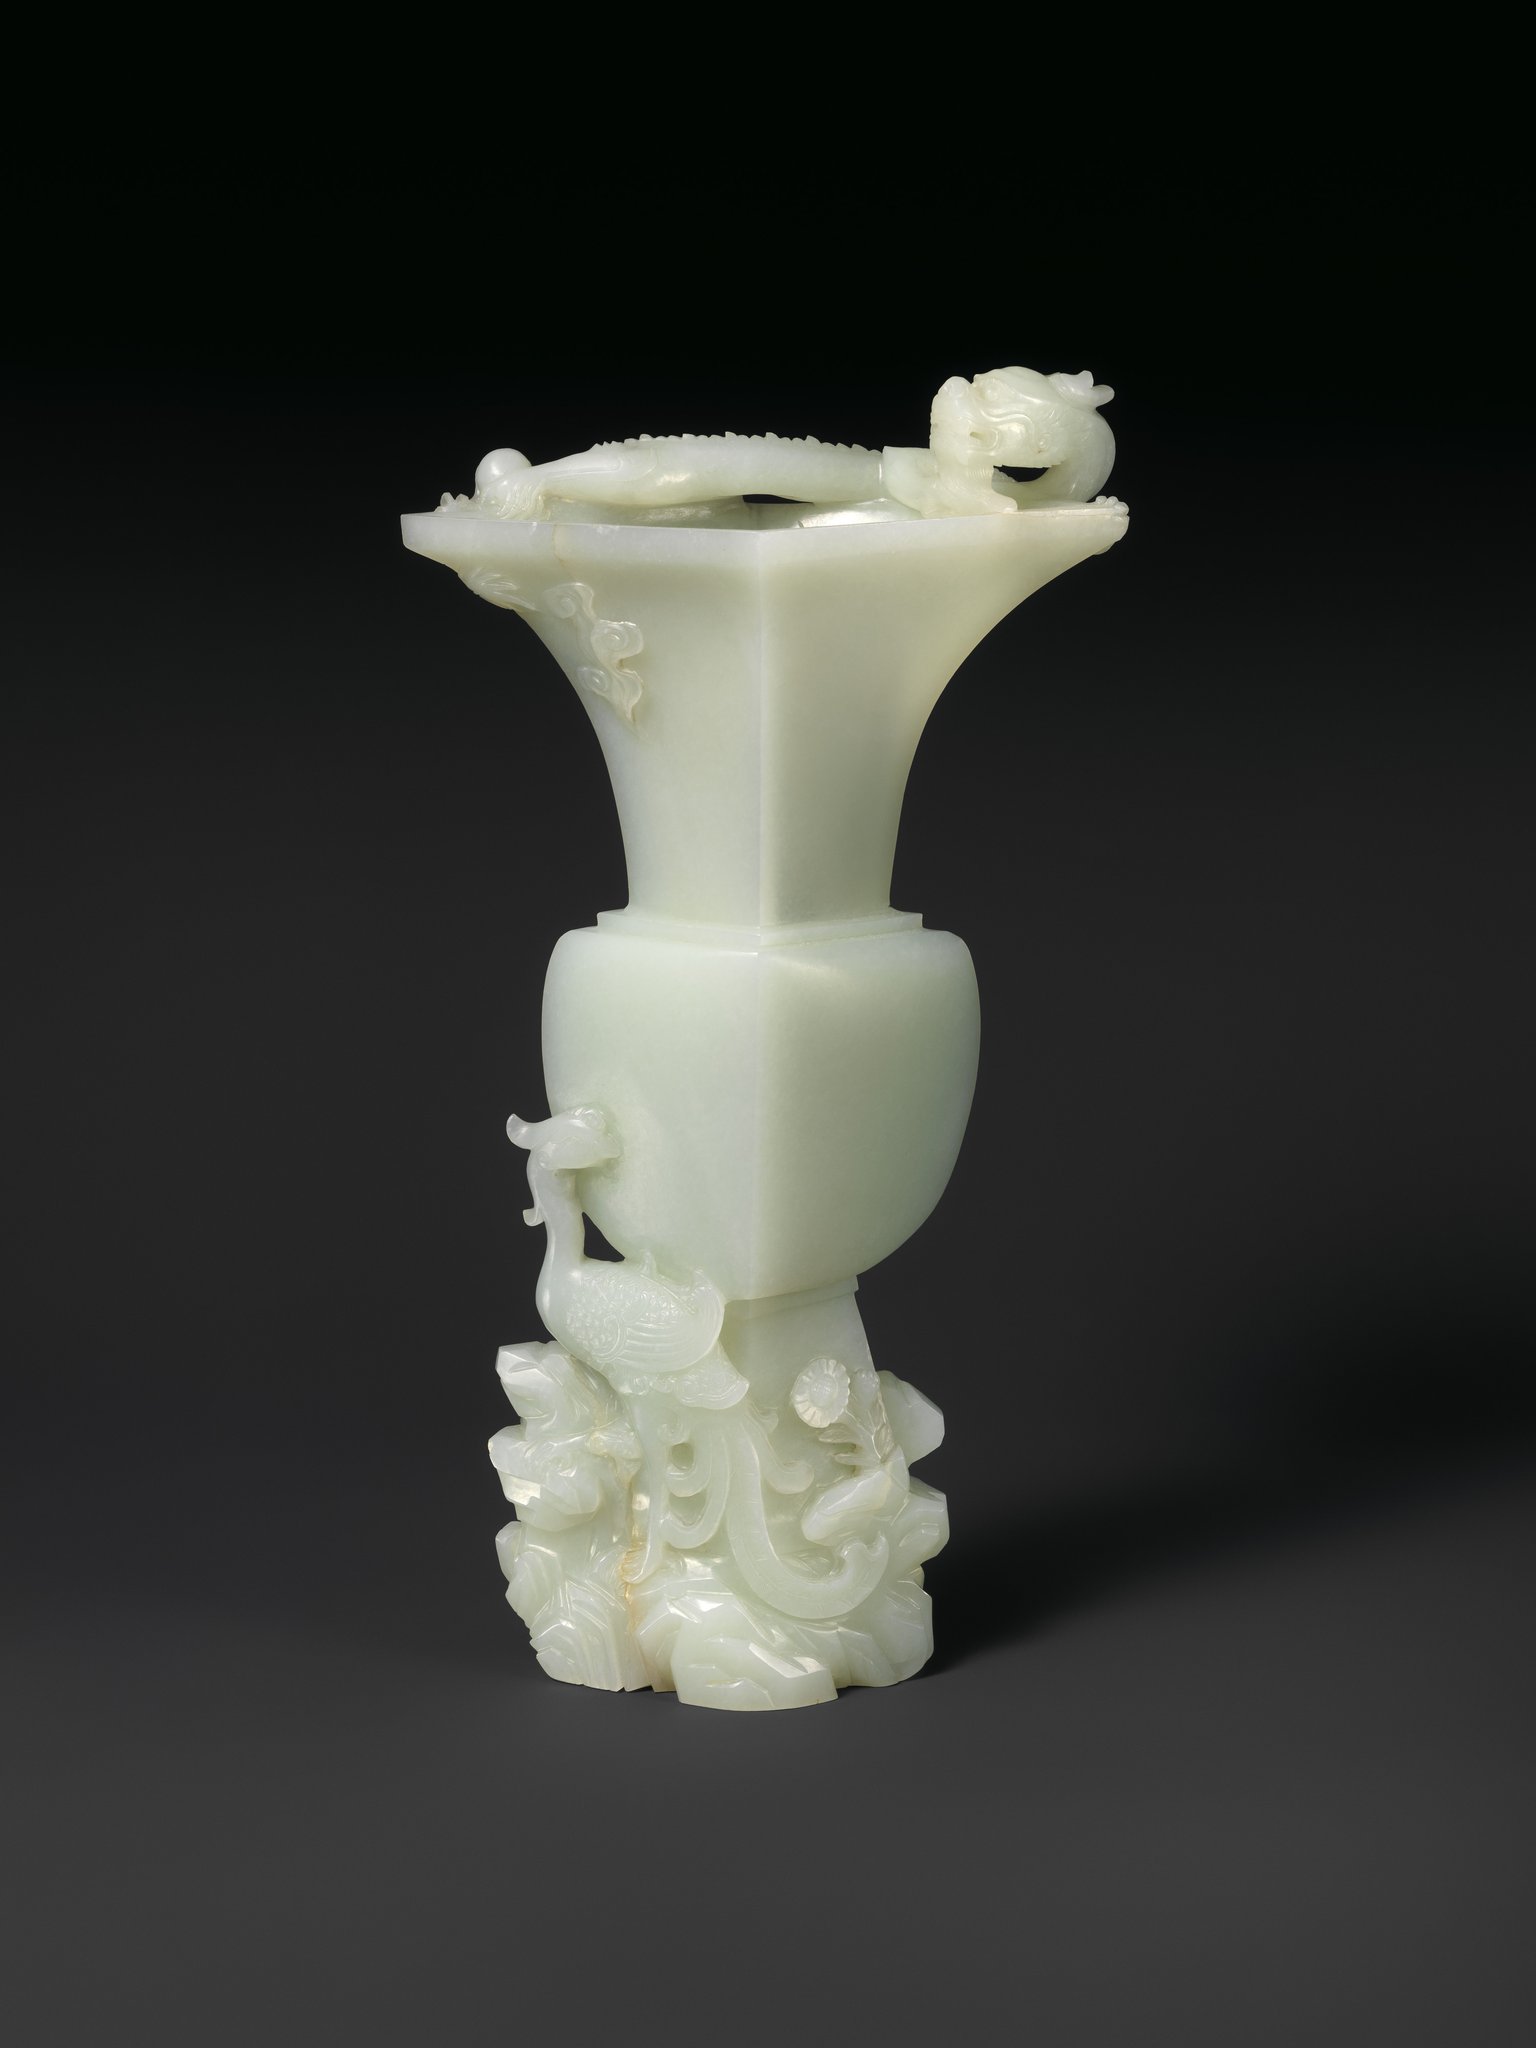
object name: vase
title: Vase with dragon and phoenix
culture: chinese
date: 1701-1900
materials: jade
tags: dragons